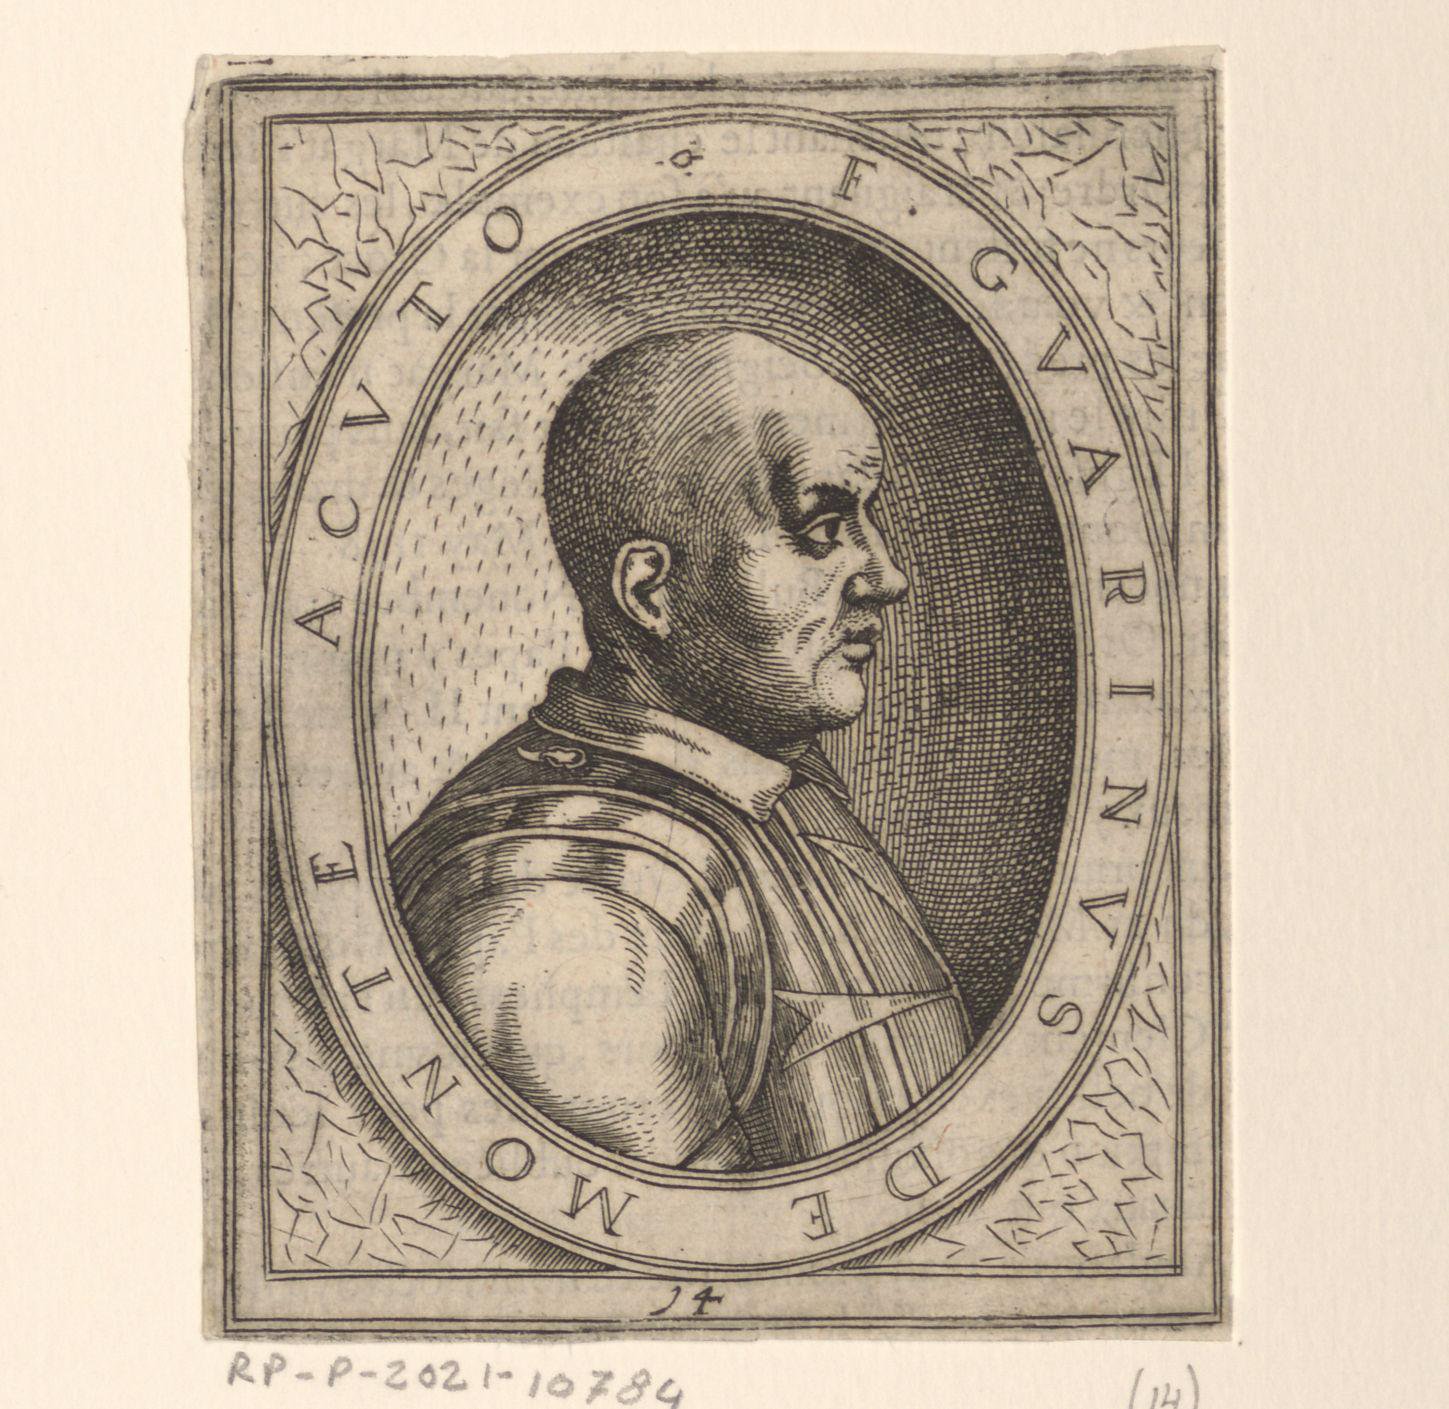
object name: print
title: Portret van Guérin de Montaigu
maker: Anonymous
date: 1643-1659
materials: paper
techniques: engraving, etching, letterpress printing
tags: historical persons, military orders, e.g.: knights templars, knights of malta, teutonic knights ~ roman catholic church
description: Prent mogelijk uit: Baudoin, Jean. Histoire des chevaliers de l'ordre de s. Jean de Hierusalem (...). Parijs: Jacques Dallin, 1643. Of uit: Baudoin, Jean. Histoire des chevaliers de l'ordre de s. Jean de Hierusalem (...). Parijs: Thomas Jolly, 1659.